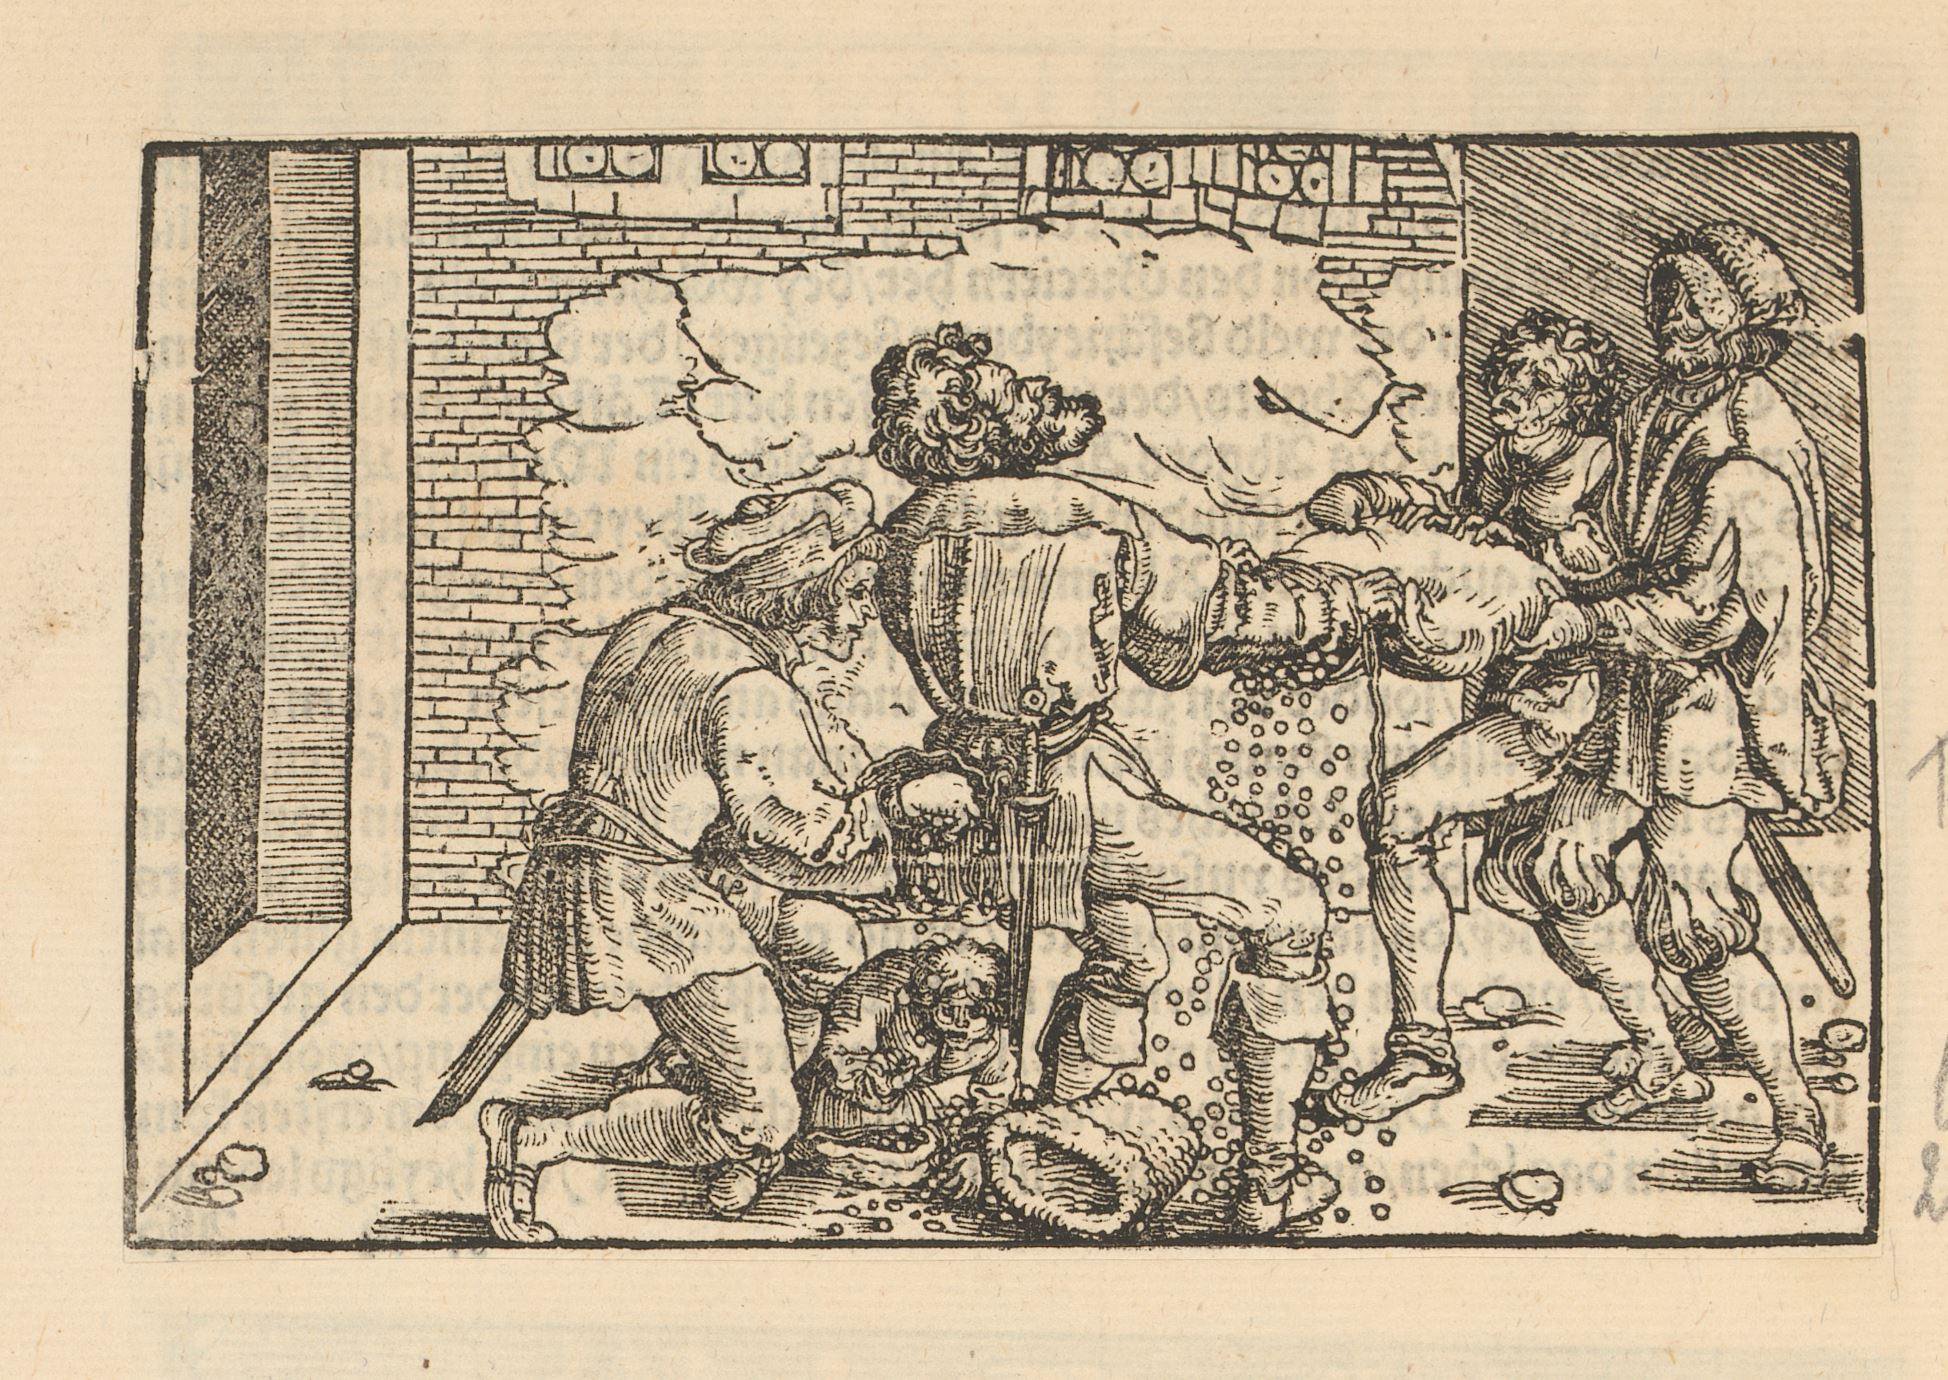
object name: album leaf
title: Man wordt van zijn geld beroofd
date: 1514-1532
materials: paper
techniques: letterpress printing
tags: theft, robbery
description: Deze prent is gebruikt in: Petrarca, Francesco. Von der Artzney bayder Glück, des guten und widerwertigen: unnd weß sich ain yeder inn Gelück und Unglück halten sol (...). Augsburg: Heinrich Steiner, 1532. Deze uitgave is ook bekend onder de titel 'Trostspiegel in Glück und Unglück'. Deze prent is ook gebruikt in: Cicero, Marcus Tulius. Officia M.T.C. Ein Buch so Marcus Tullius Cicero der Römer zu seynem (...). [Vertaald uit het Latijn door] Johann von Schwarzenberg. Augsburg: Heinrich Steiner, 1531.